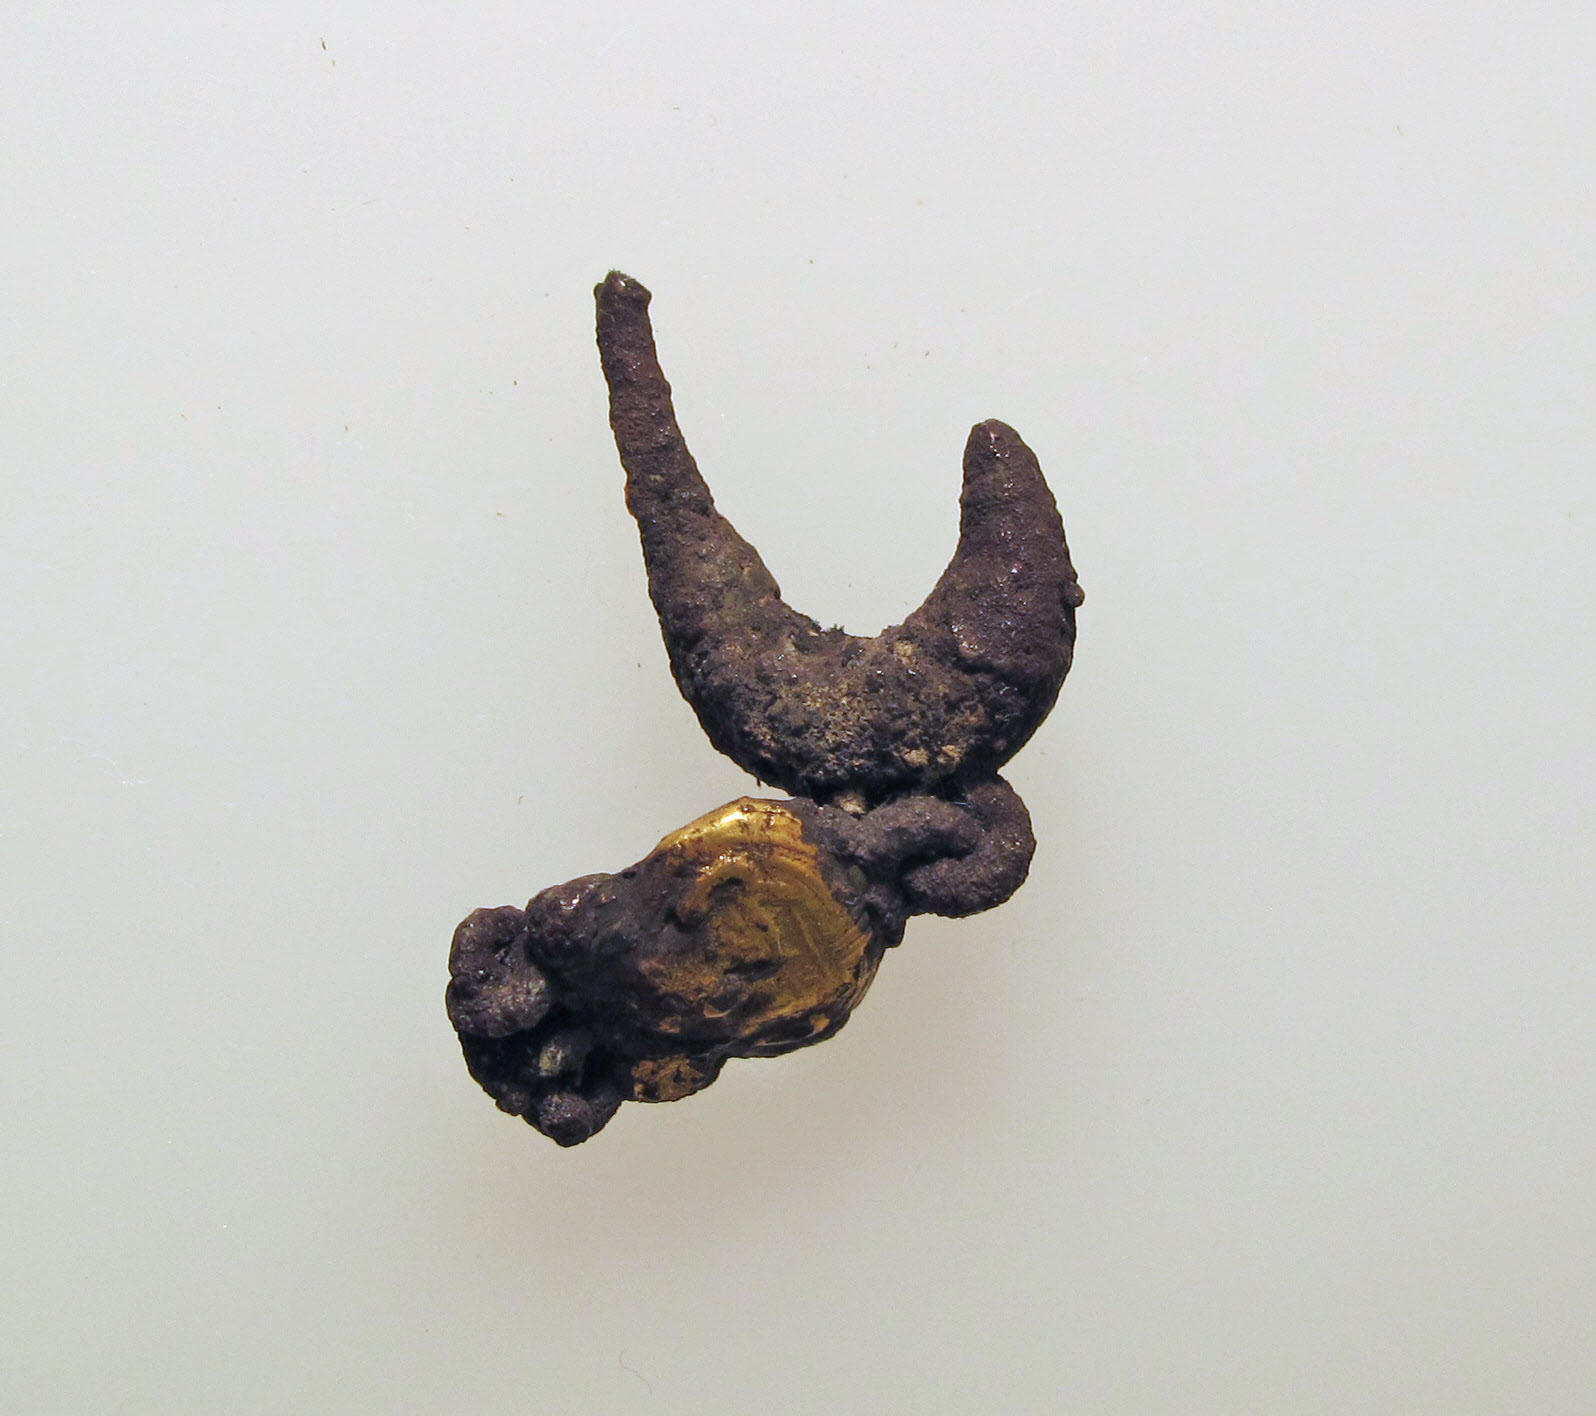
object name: pendant in the form of hathor's head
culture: cypriot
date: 3900 BCE-100 CE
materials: silver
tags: hathor